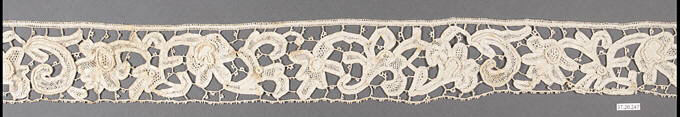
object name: band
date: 1601-1700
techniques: lace